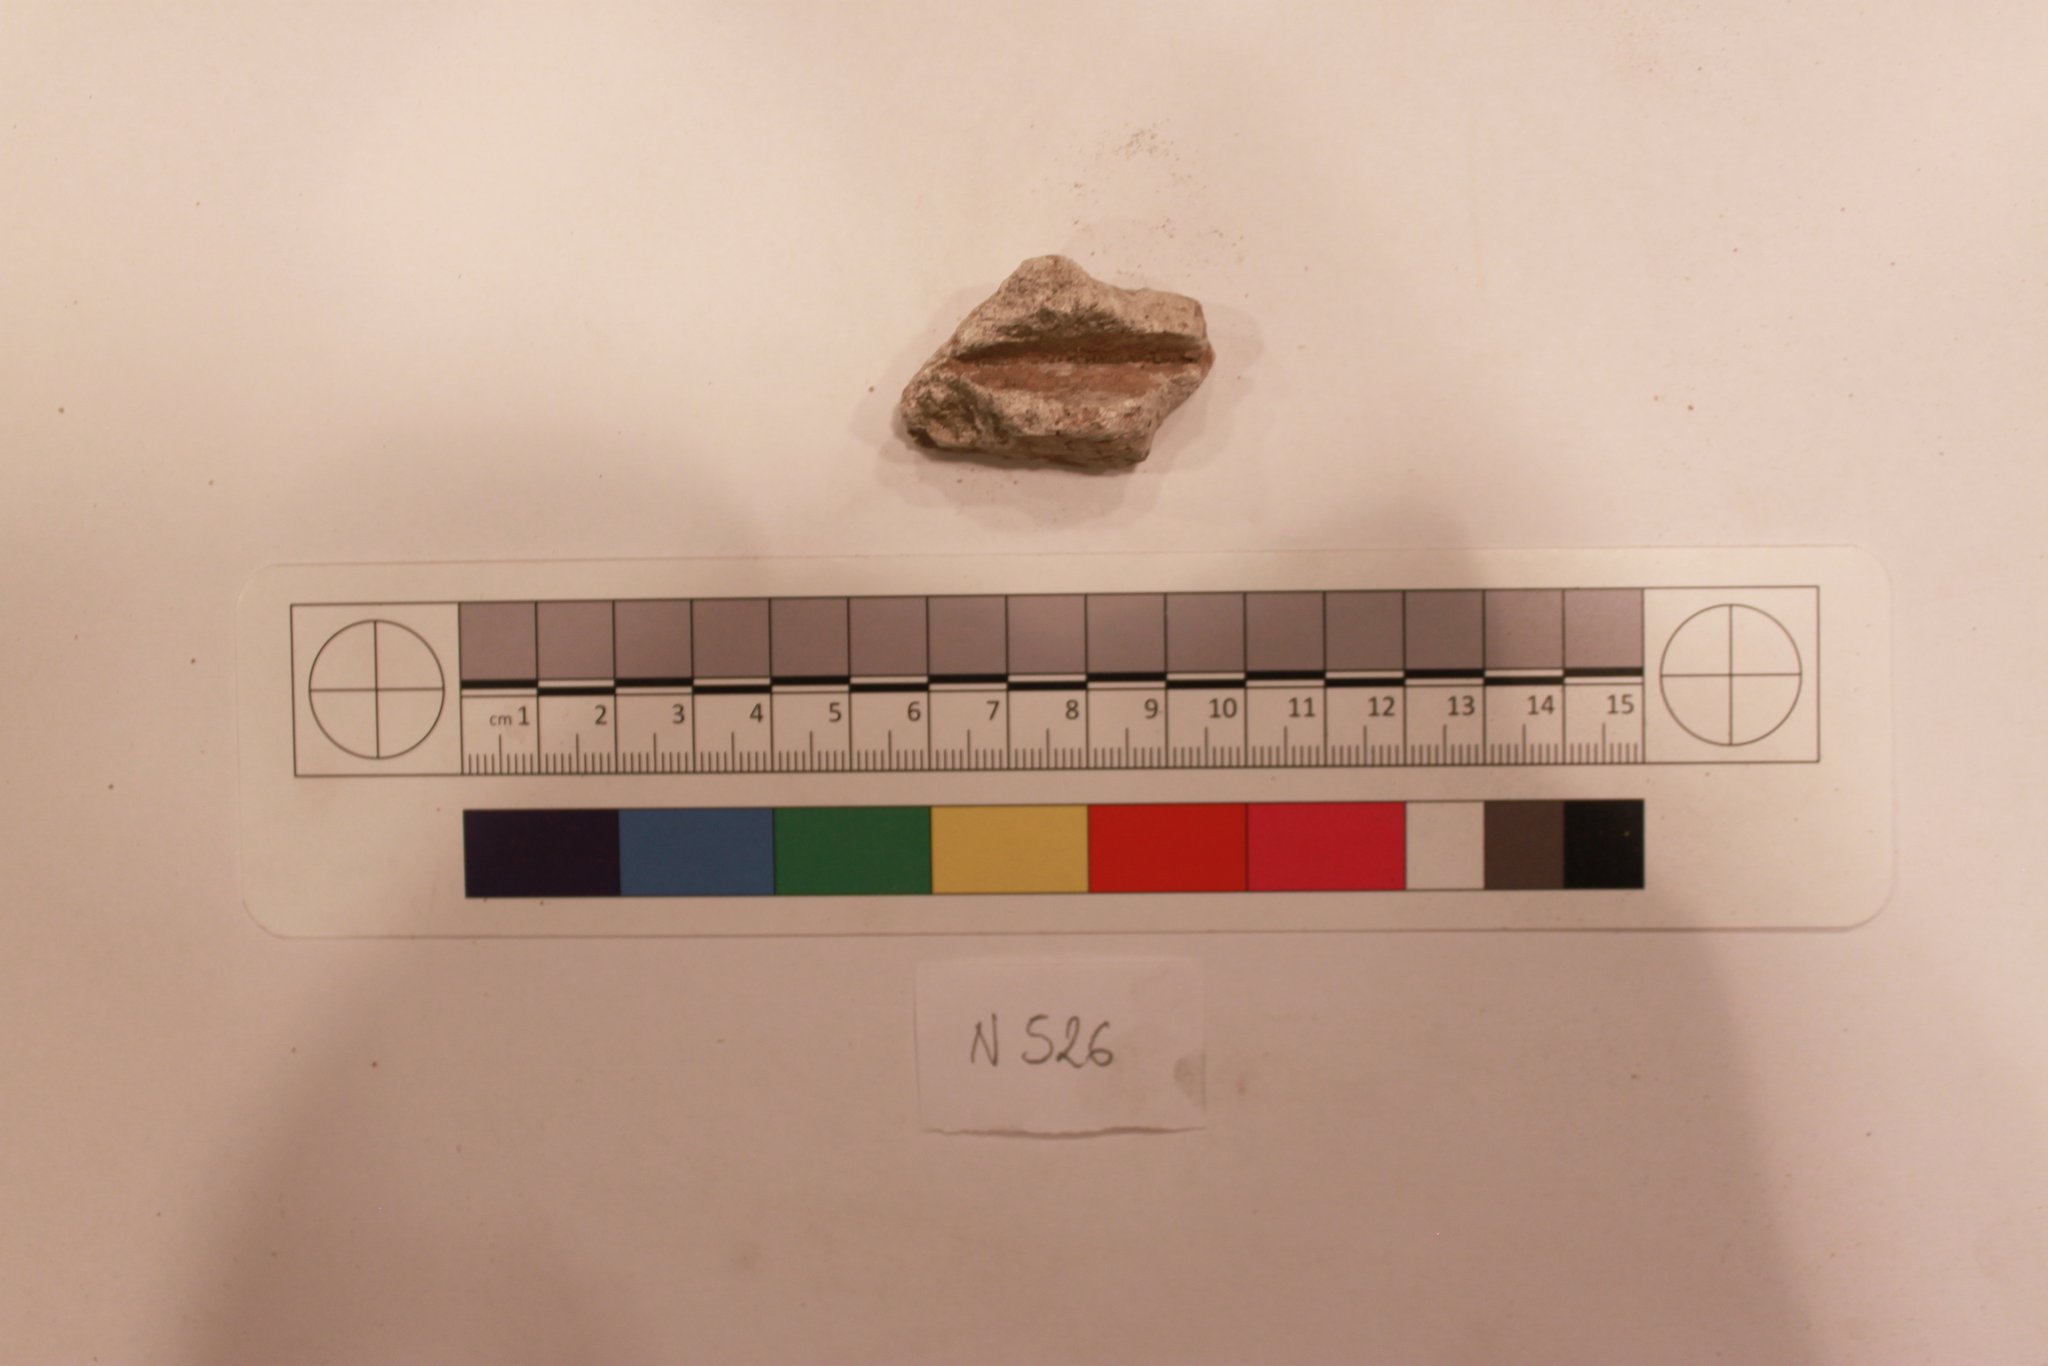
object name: fragment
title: Stucco Fragment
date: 701-1200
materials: plaster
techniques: carving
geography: iran